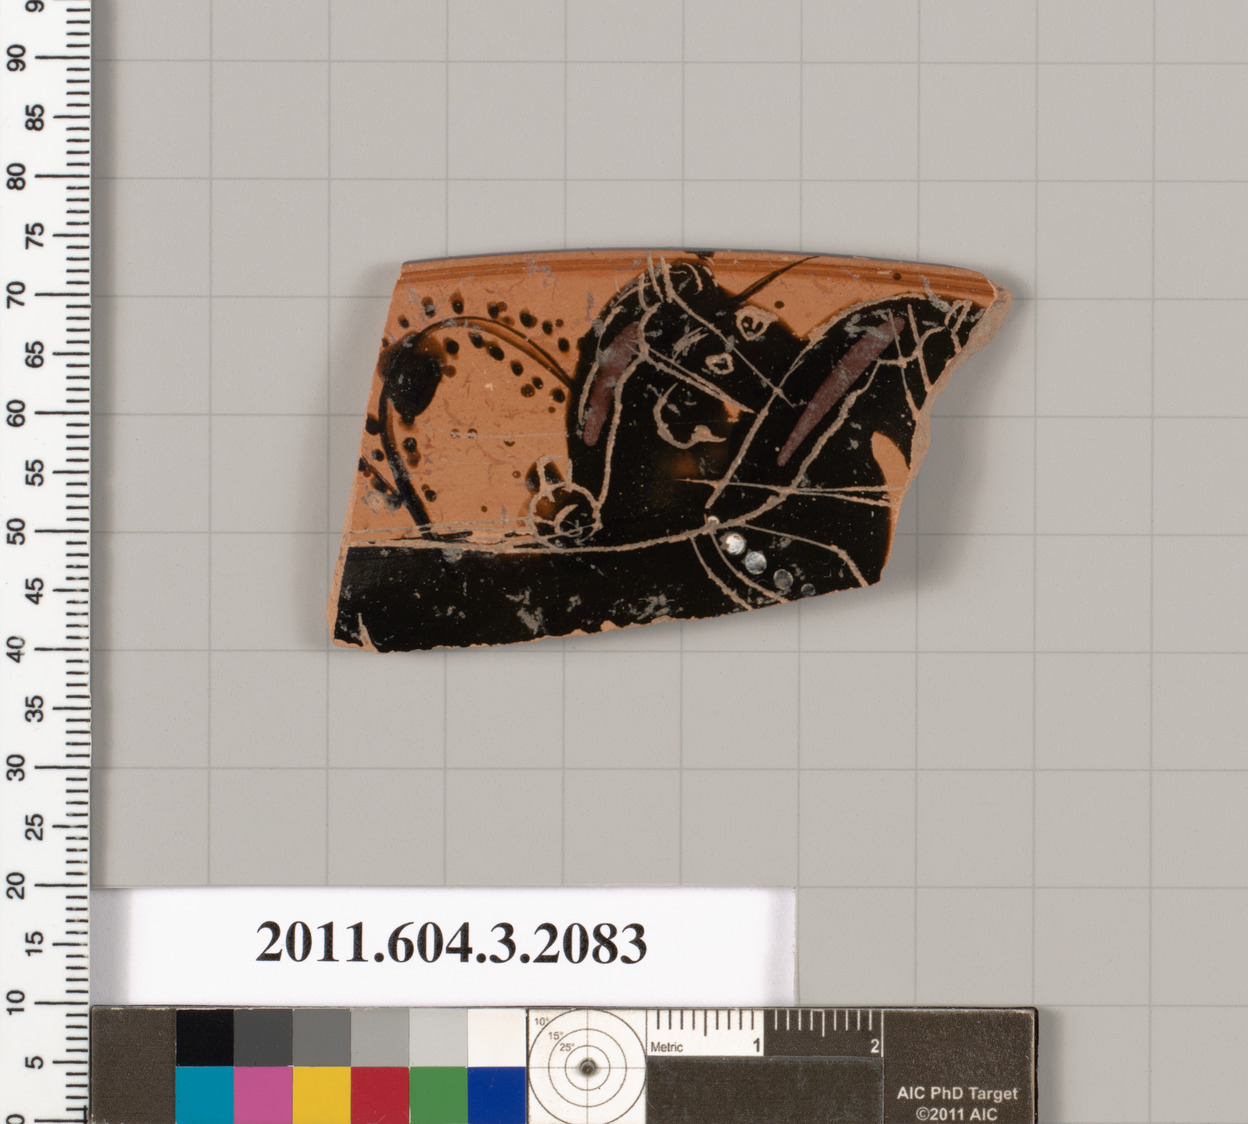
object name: kylix fragment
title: Terracotta rim fragment of a kylix (drinking cup)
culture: greek, attic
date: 534-501 BCE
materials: terracotta